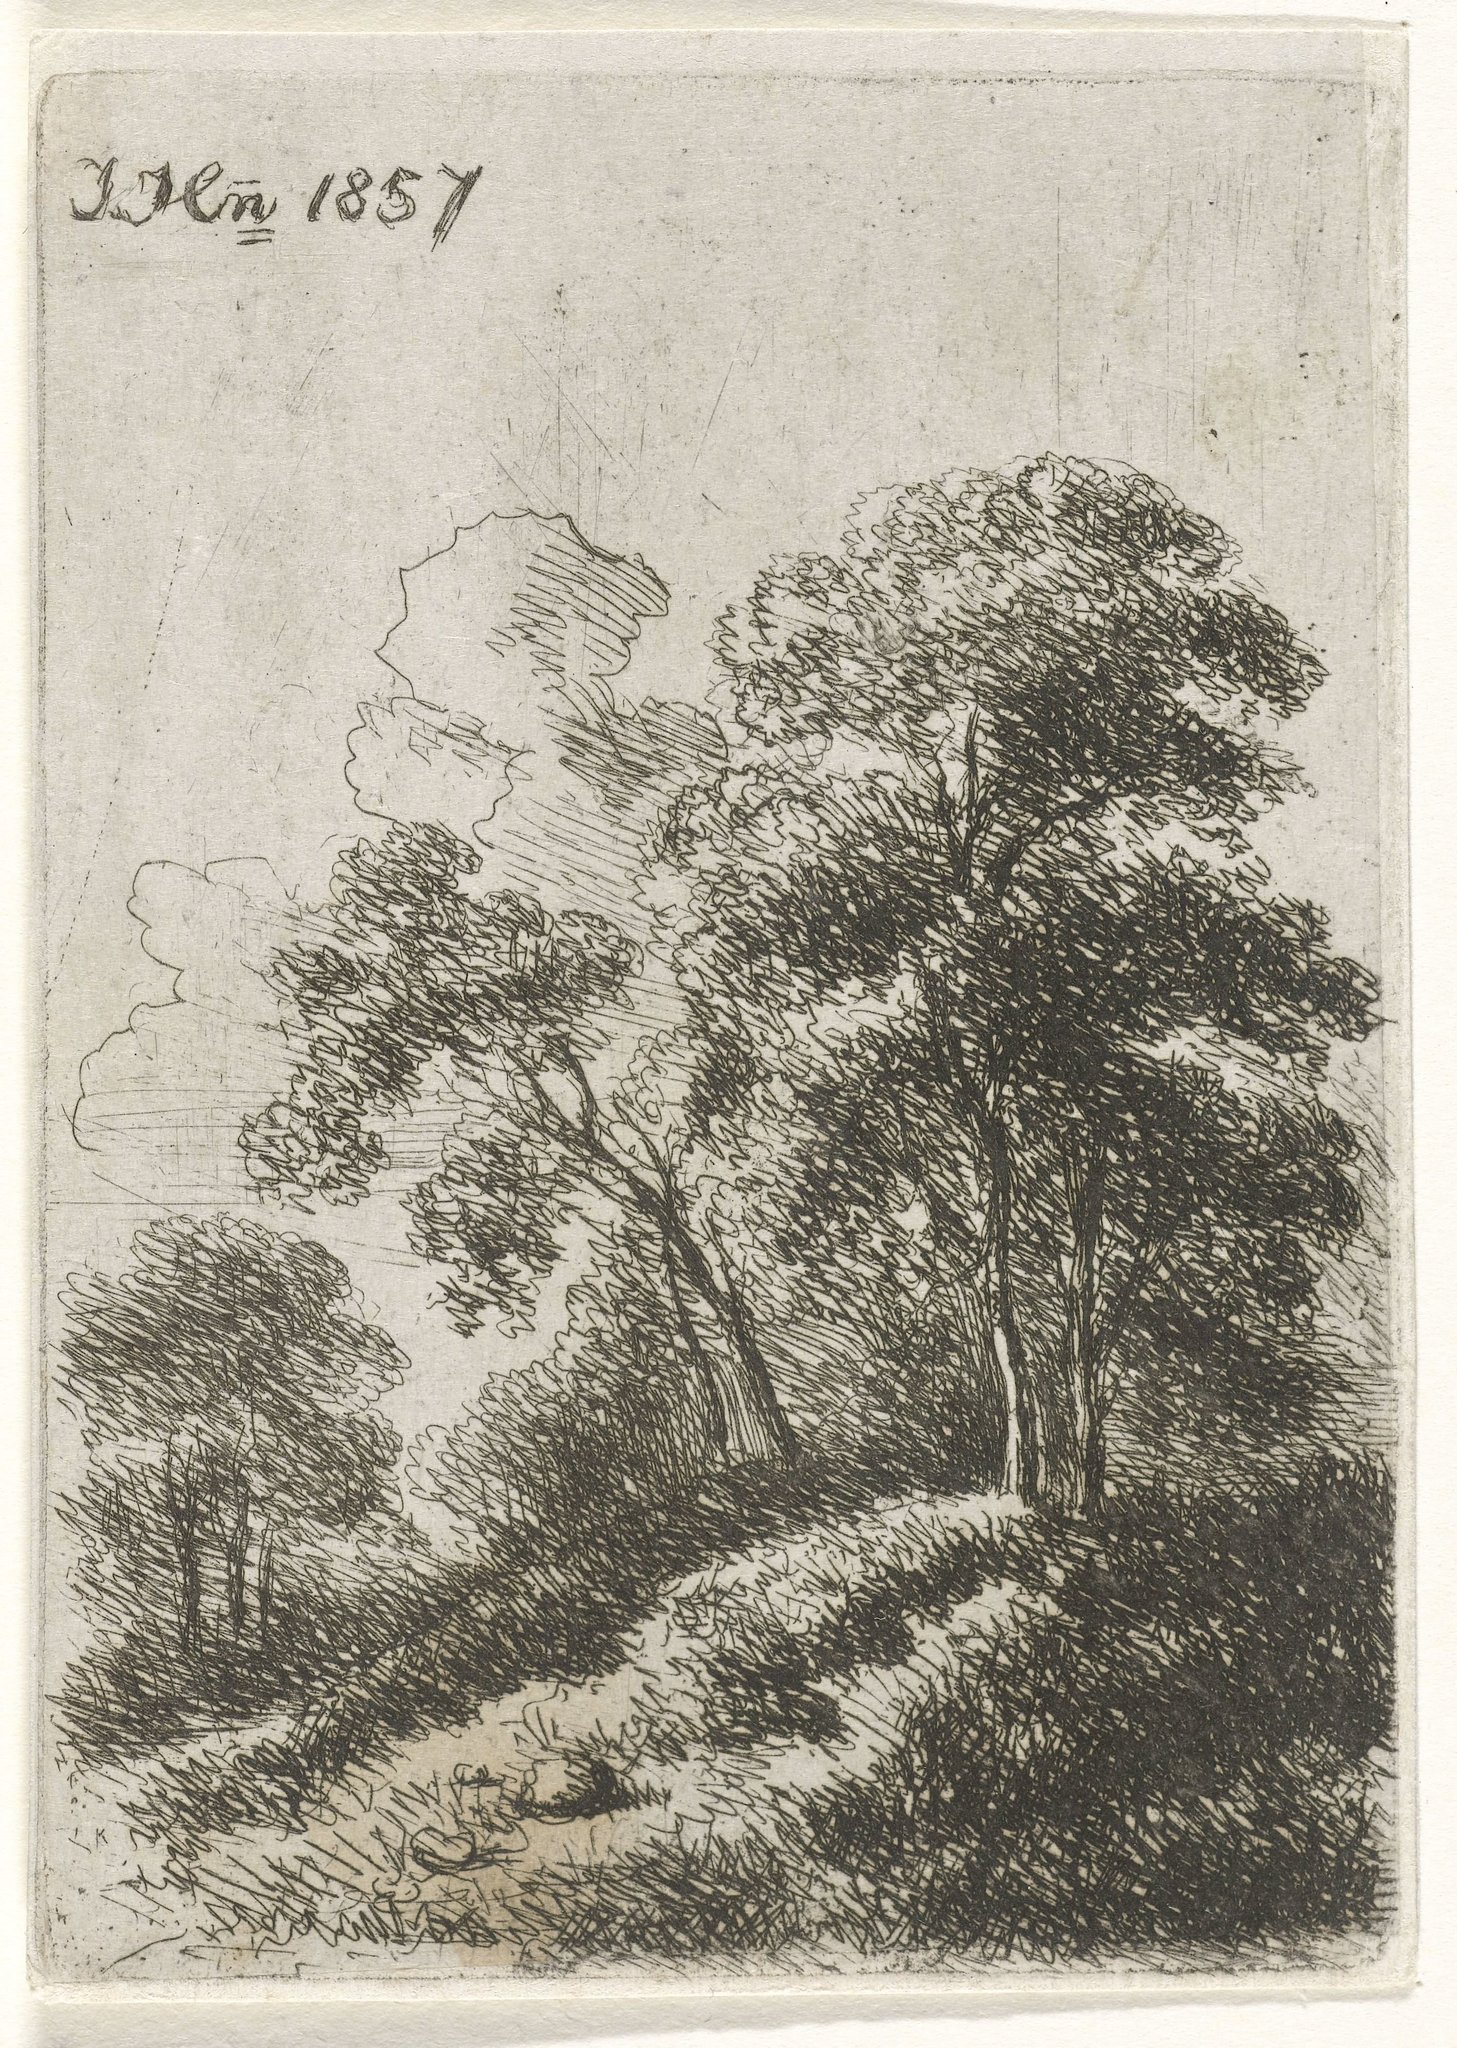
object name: print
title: Bomen op een heuvel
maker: hendrik jan hein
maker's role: print maker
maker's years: 1822-1866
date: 1857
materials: paper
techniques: etching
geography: kampen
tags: trees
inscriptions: collector's mark: Lugt 2228